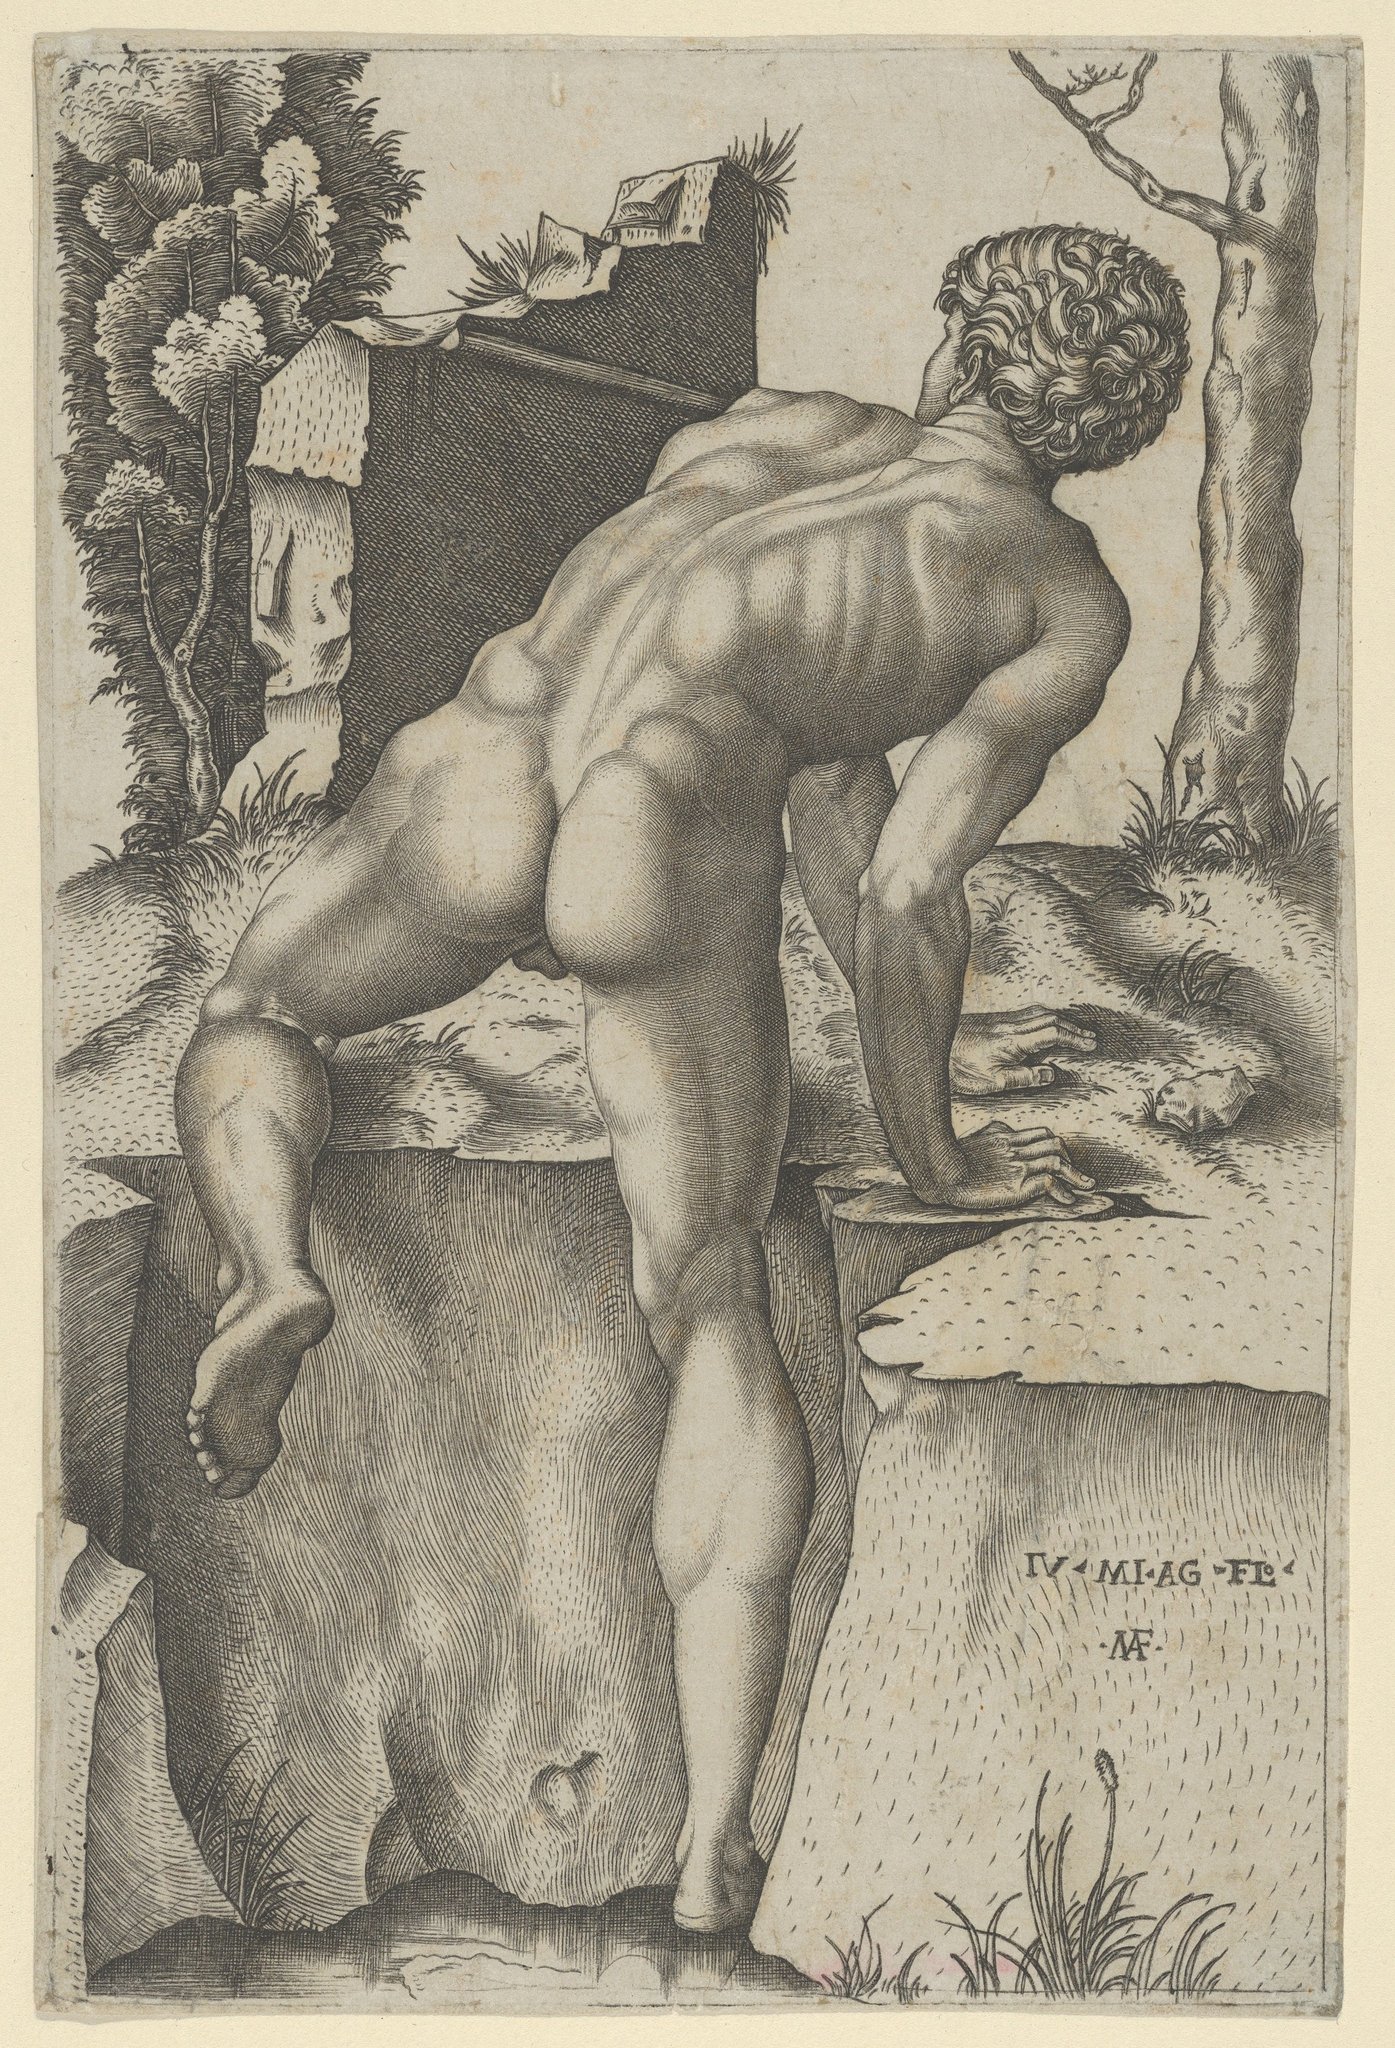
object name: print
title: Naked man viewed from behind climbing a river bank, after Michelangelo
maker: marcantonio raimondi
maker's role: artist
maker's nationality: italian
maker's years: 1475-1534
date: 1509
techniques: engraving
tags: male nudes